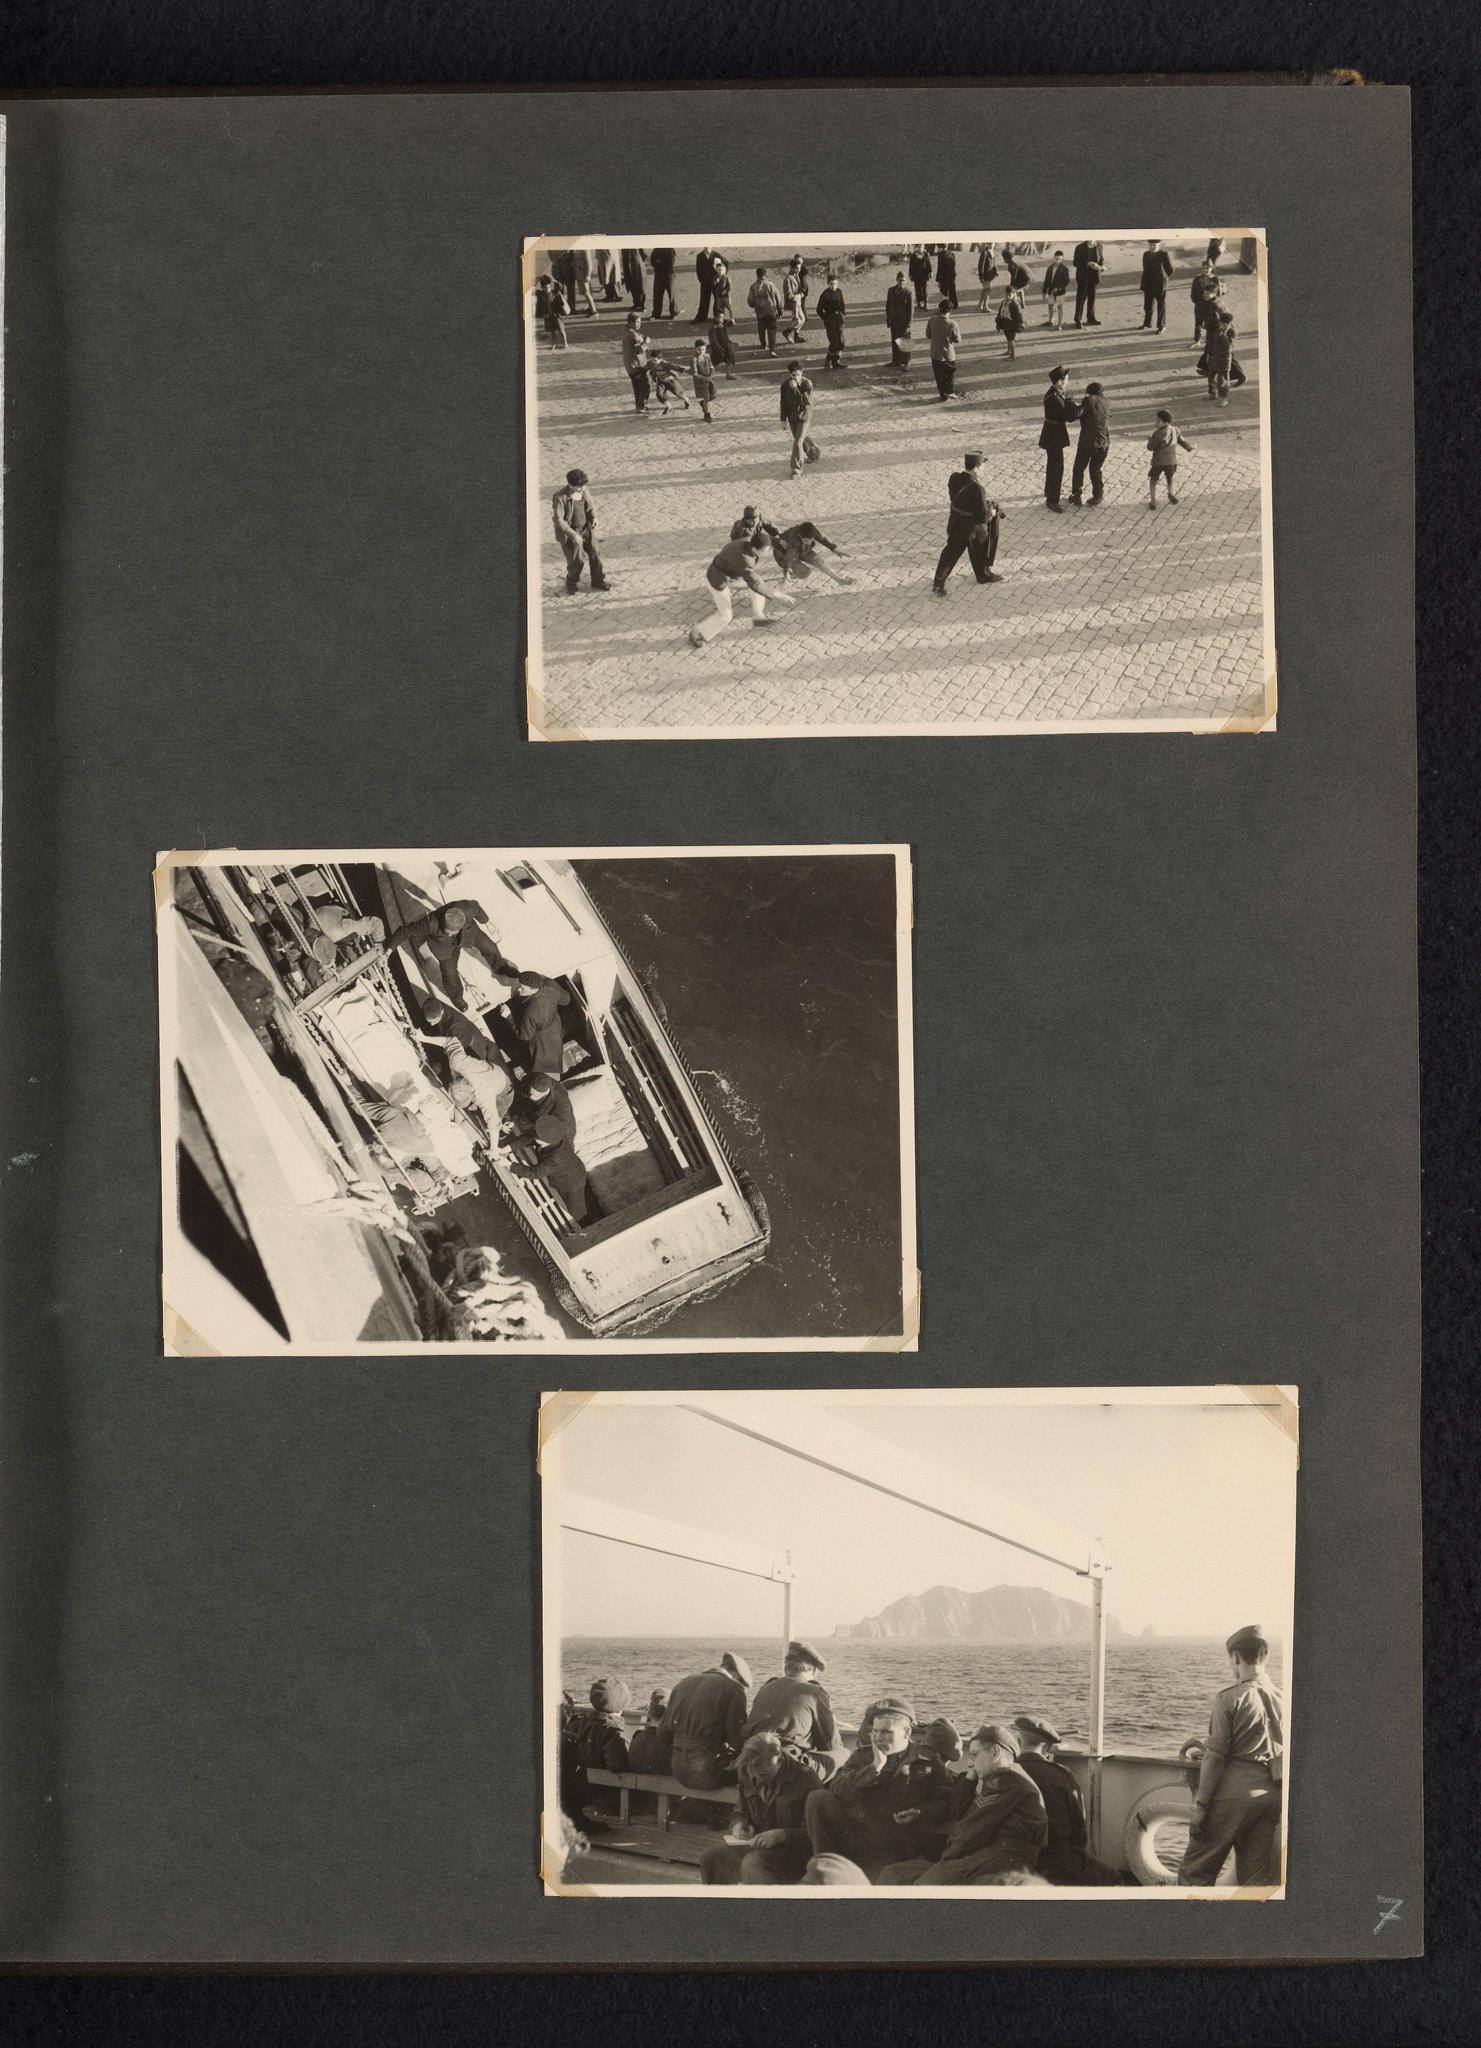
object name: photograph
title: Tussenstop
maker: Anonymous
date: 1947-1948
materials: cardboard, photographic support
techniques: gelatin silver print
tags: troop movements, transportation, rocky coast, quay, steamship, motorship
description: Albumblad met drie foto's van mensen op de kade, een boot langszij en militairen aan boord, genomen vanaf de S.S. Waterman op weg naar Nederlands-Indië. Onderdeel van het fotoalbum 'Mijn jaren in Indië' met foto's over de militaire acties in Nederlands-Indië.